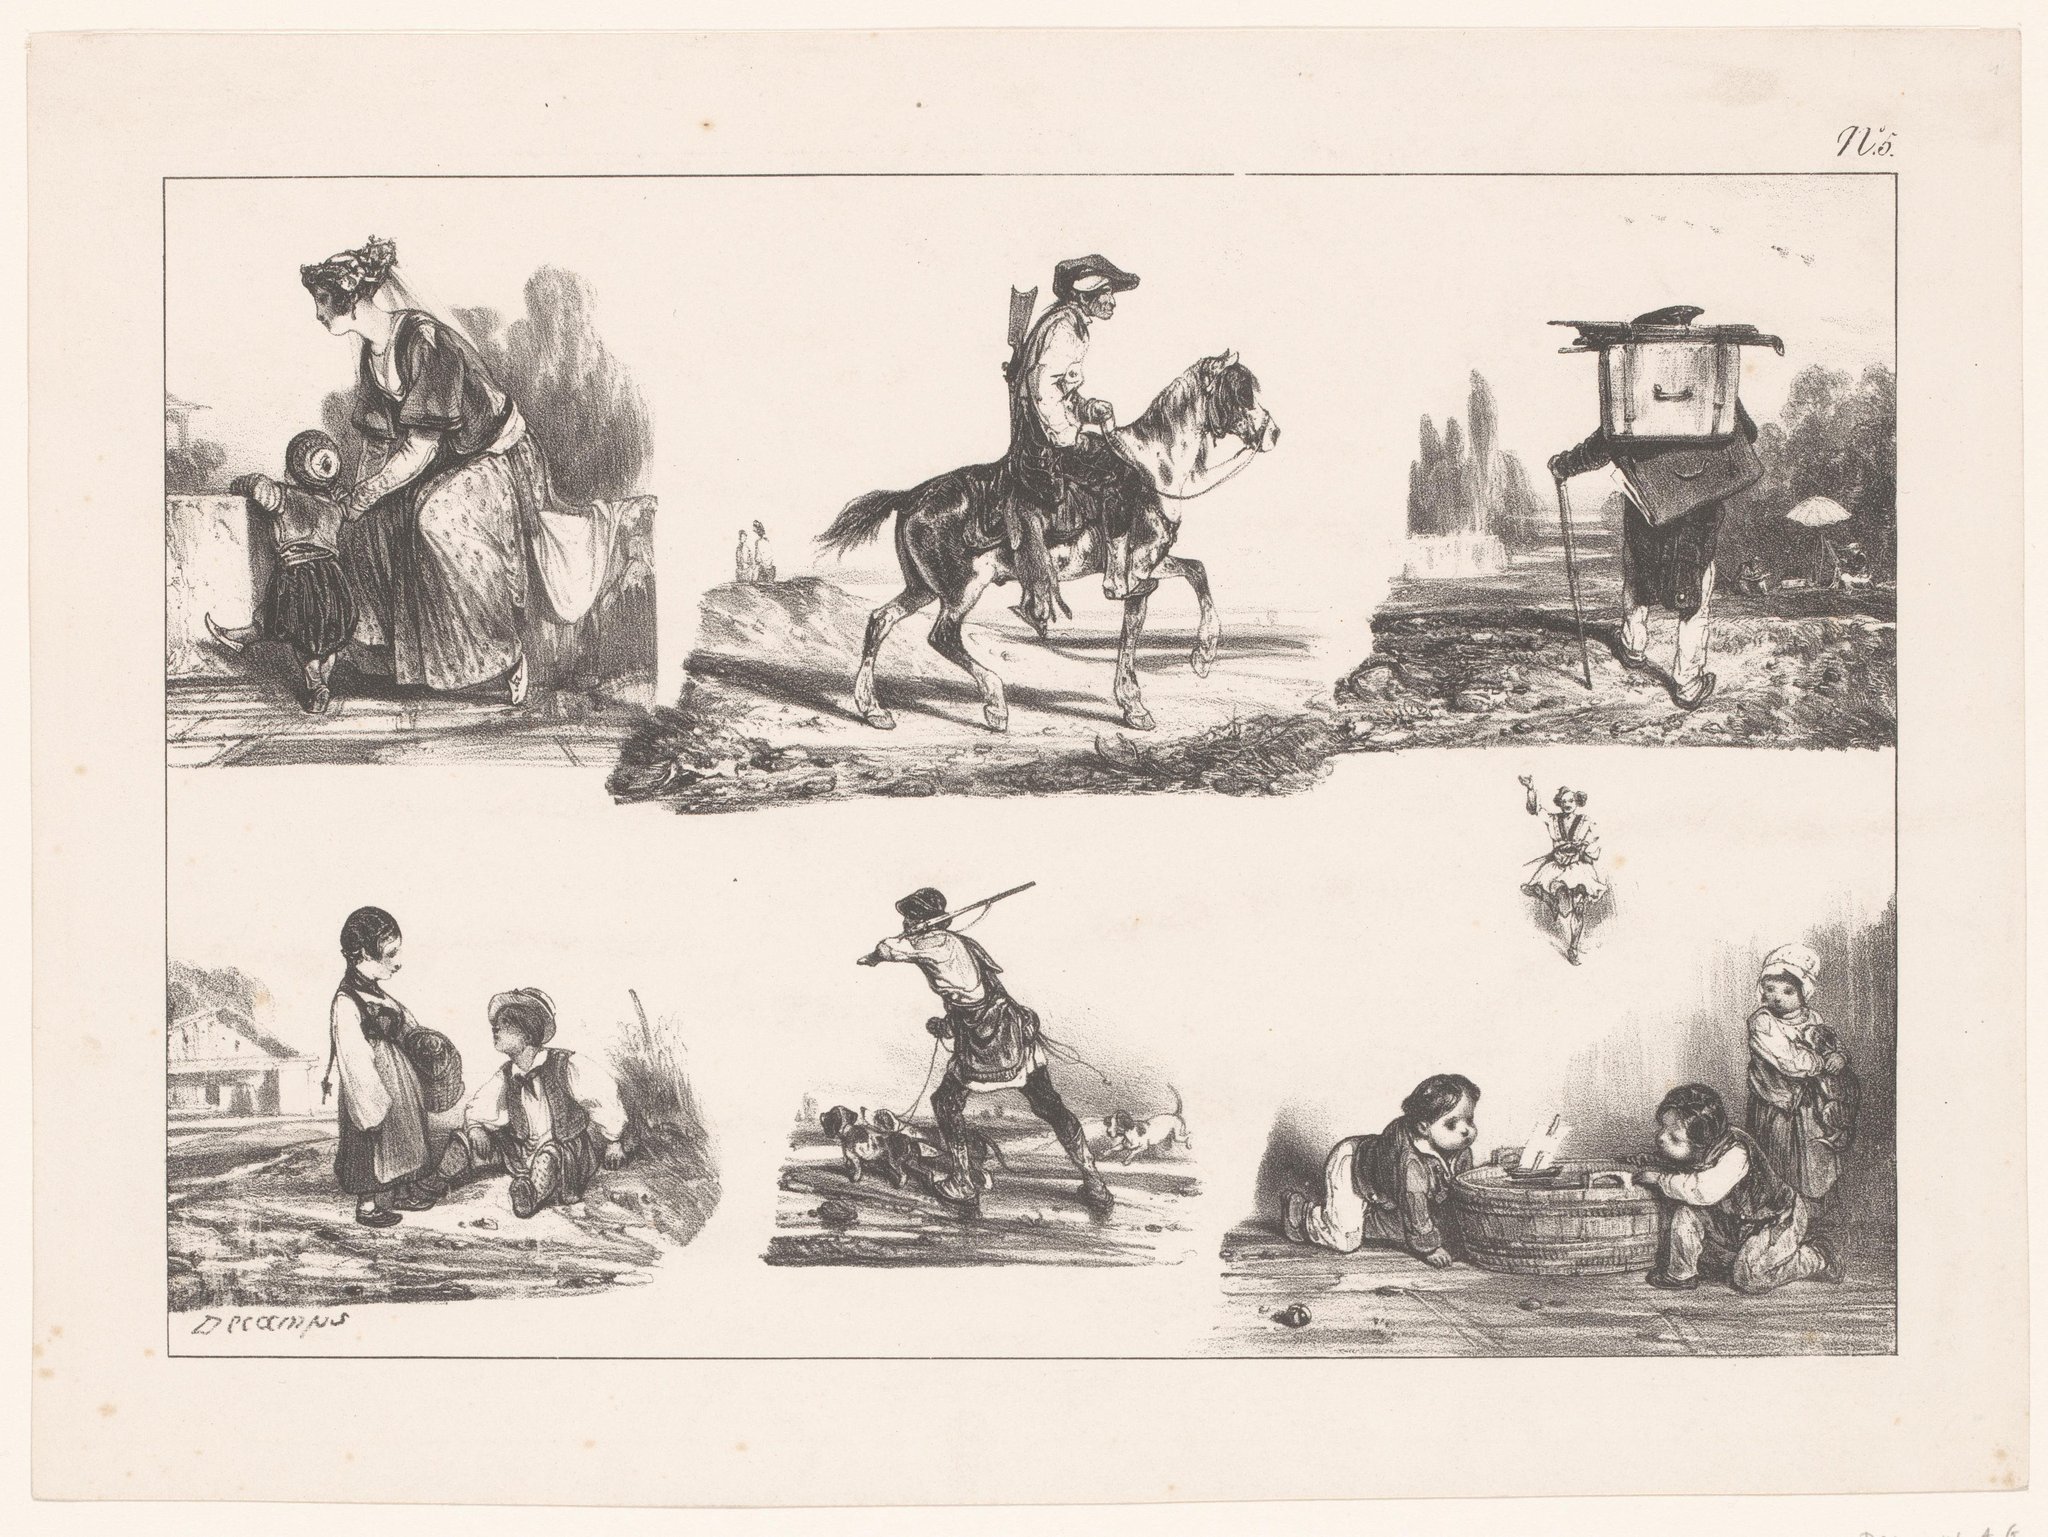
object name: print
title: Genrevoorstellingen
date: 1829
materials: paper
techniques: lithograph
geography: paris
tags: hunter, child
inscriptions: collector's mark: Lugt 2760, collector's mark: Lugt 2228a